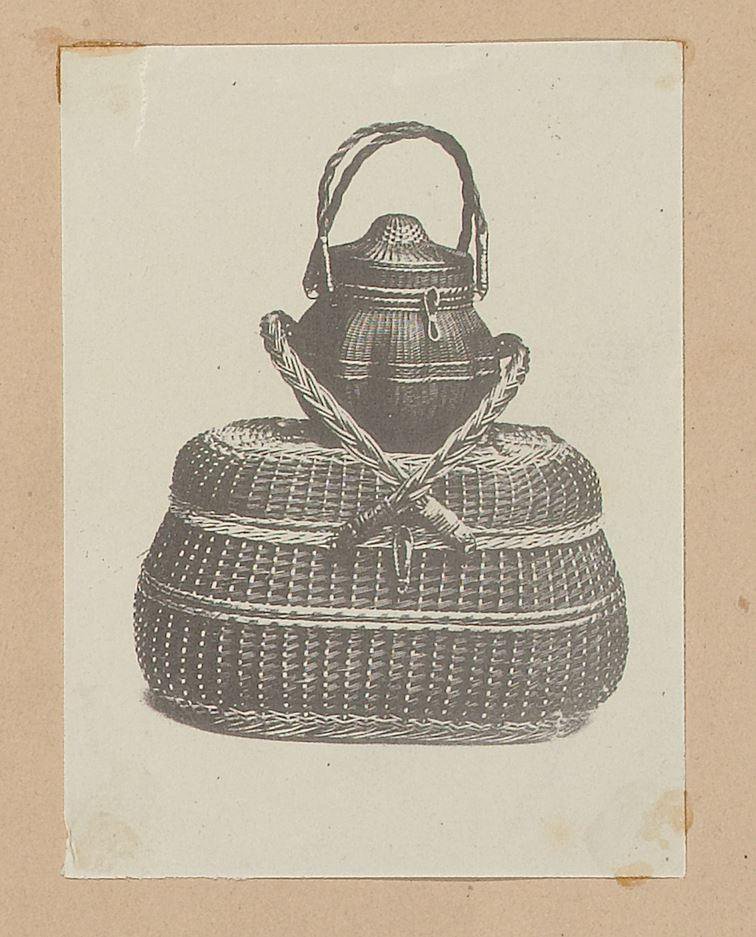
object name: photograph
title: Twee rieten manden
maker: eduard isaac asser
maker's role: amateurfotograaf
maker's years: 1809-1894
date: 1857-1865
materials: cardboard, paper, photographic support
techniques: photolithography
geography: amsterdam